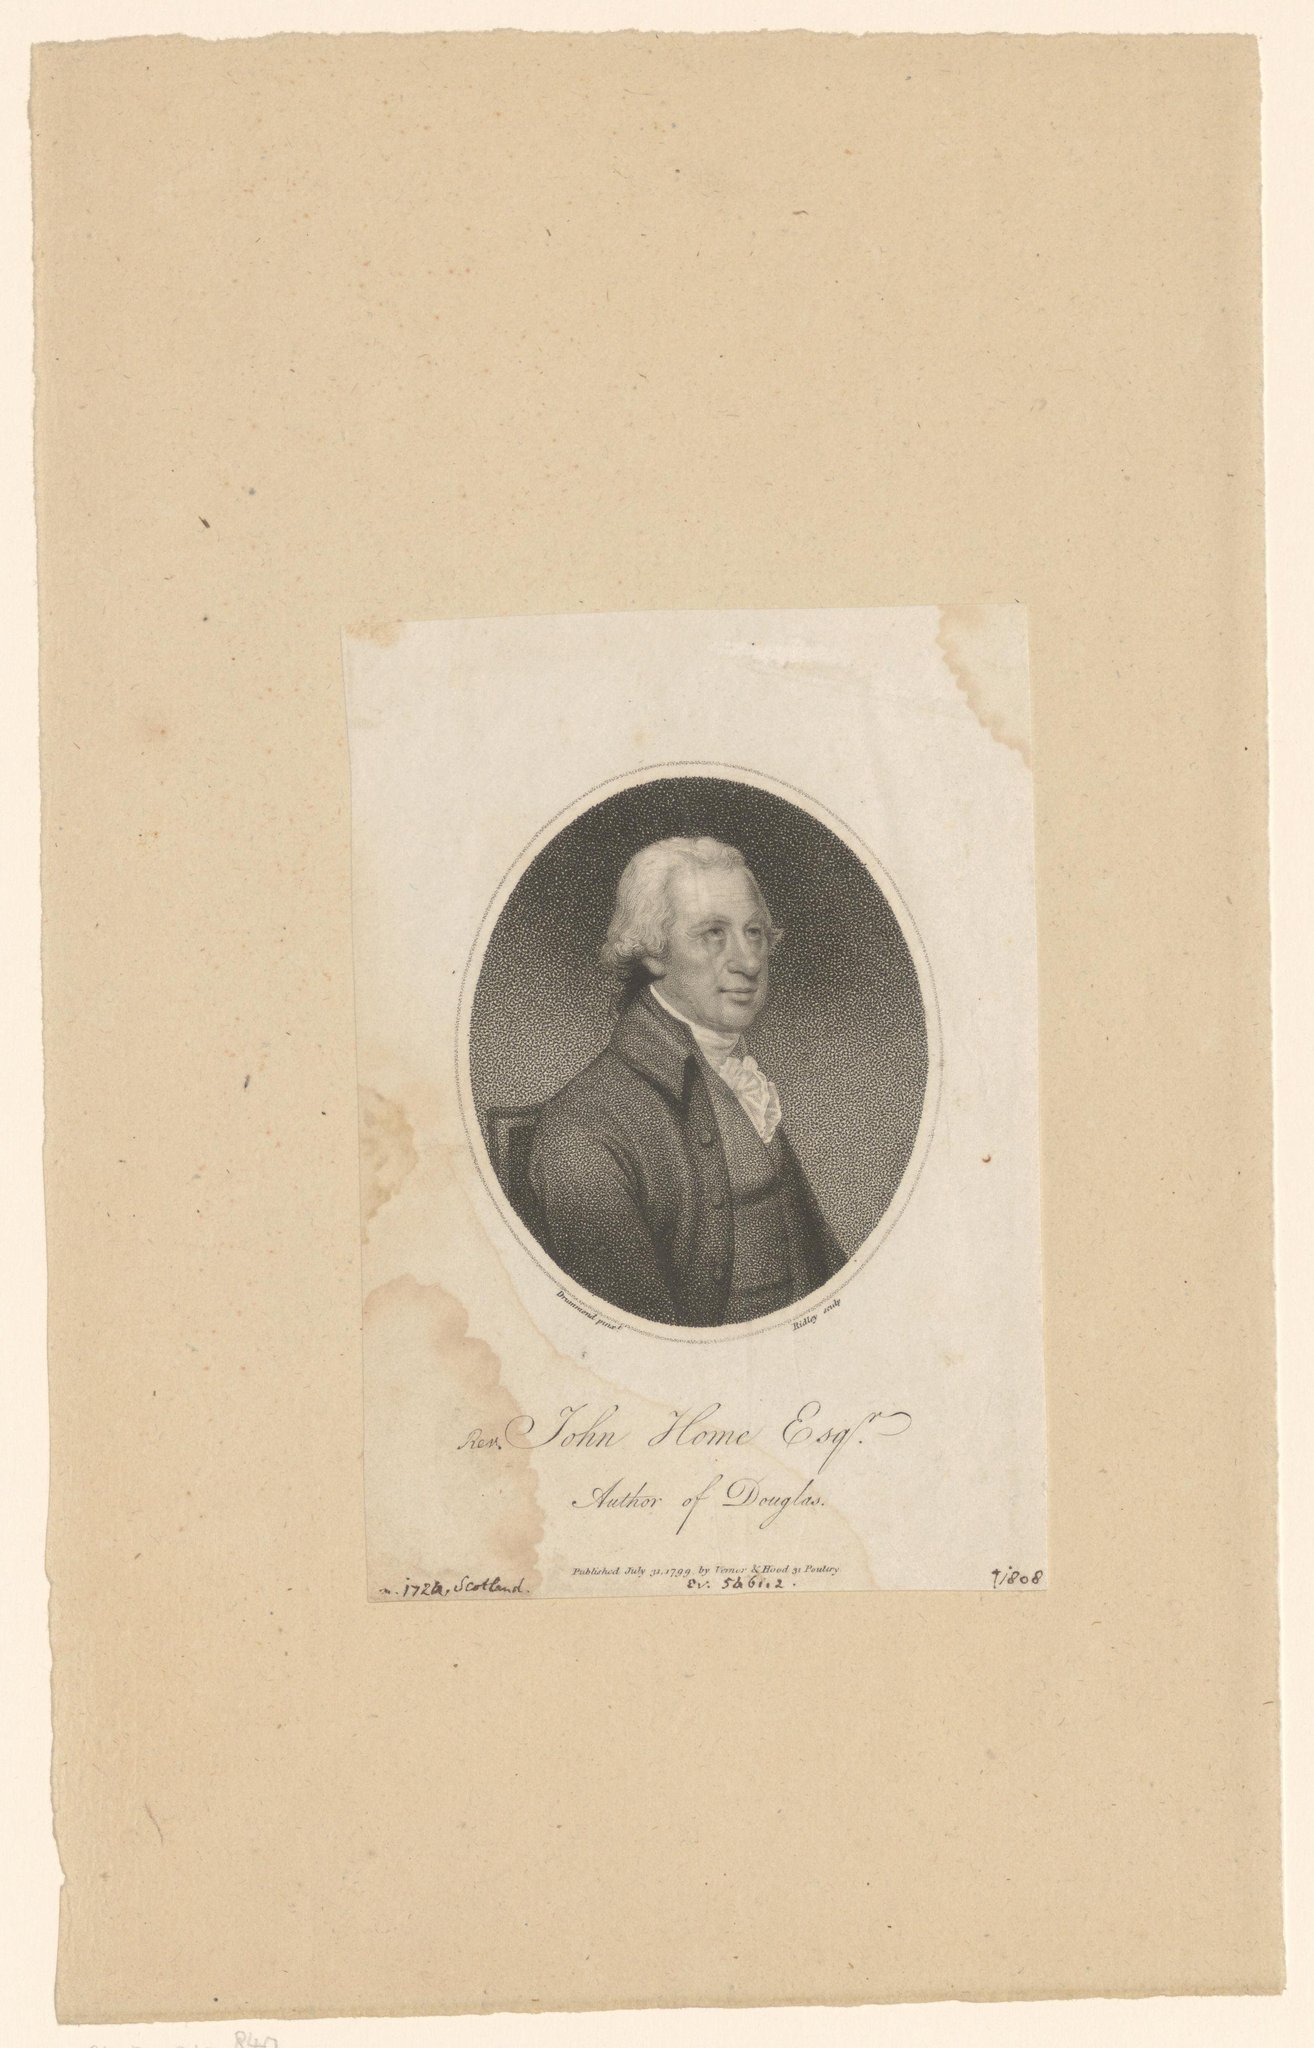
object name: print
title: Portret van John Home Esqr.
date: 1799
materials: paper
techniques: stippling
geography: london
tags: historical persons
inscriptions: collector's mark: Lugt 2228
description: Prent gebruikt in: The Monthly Mirror (1799).